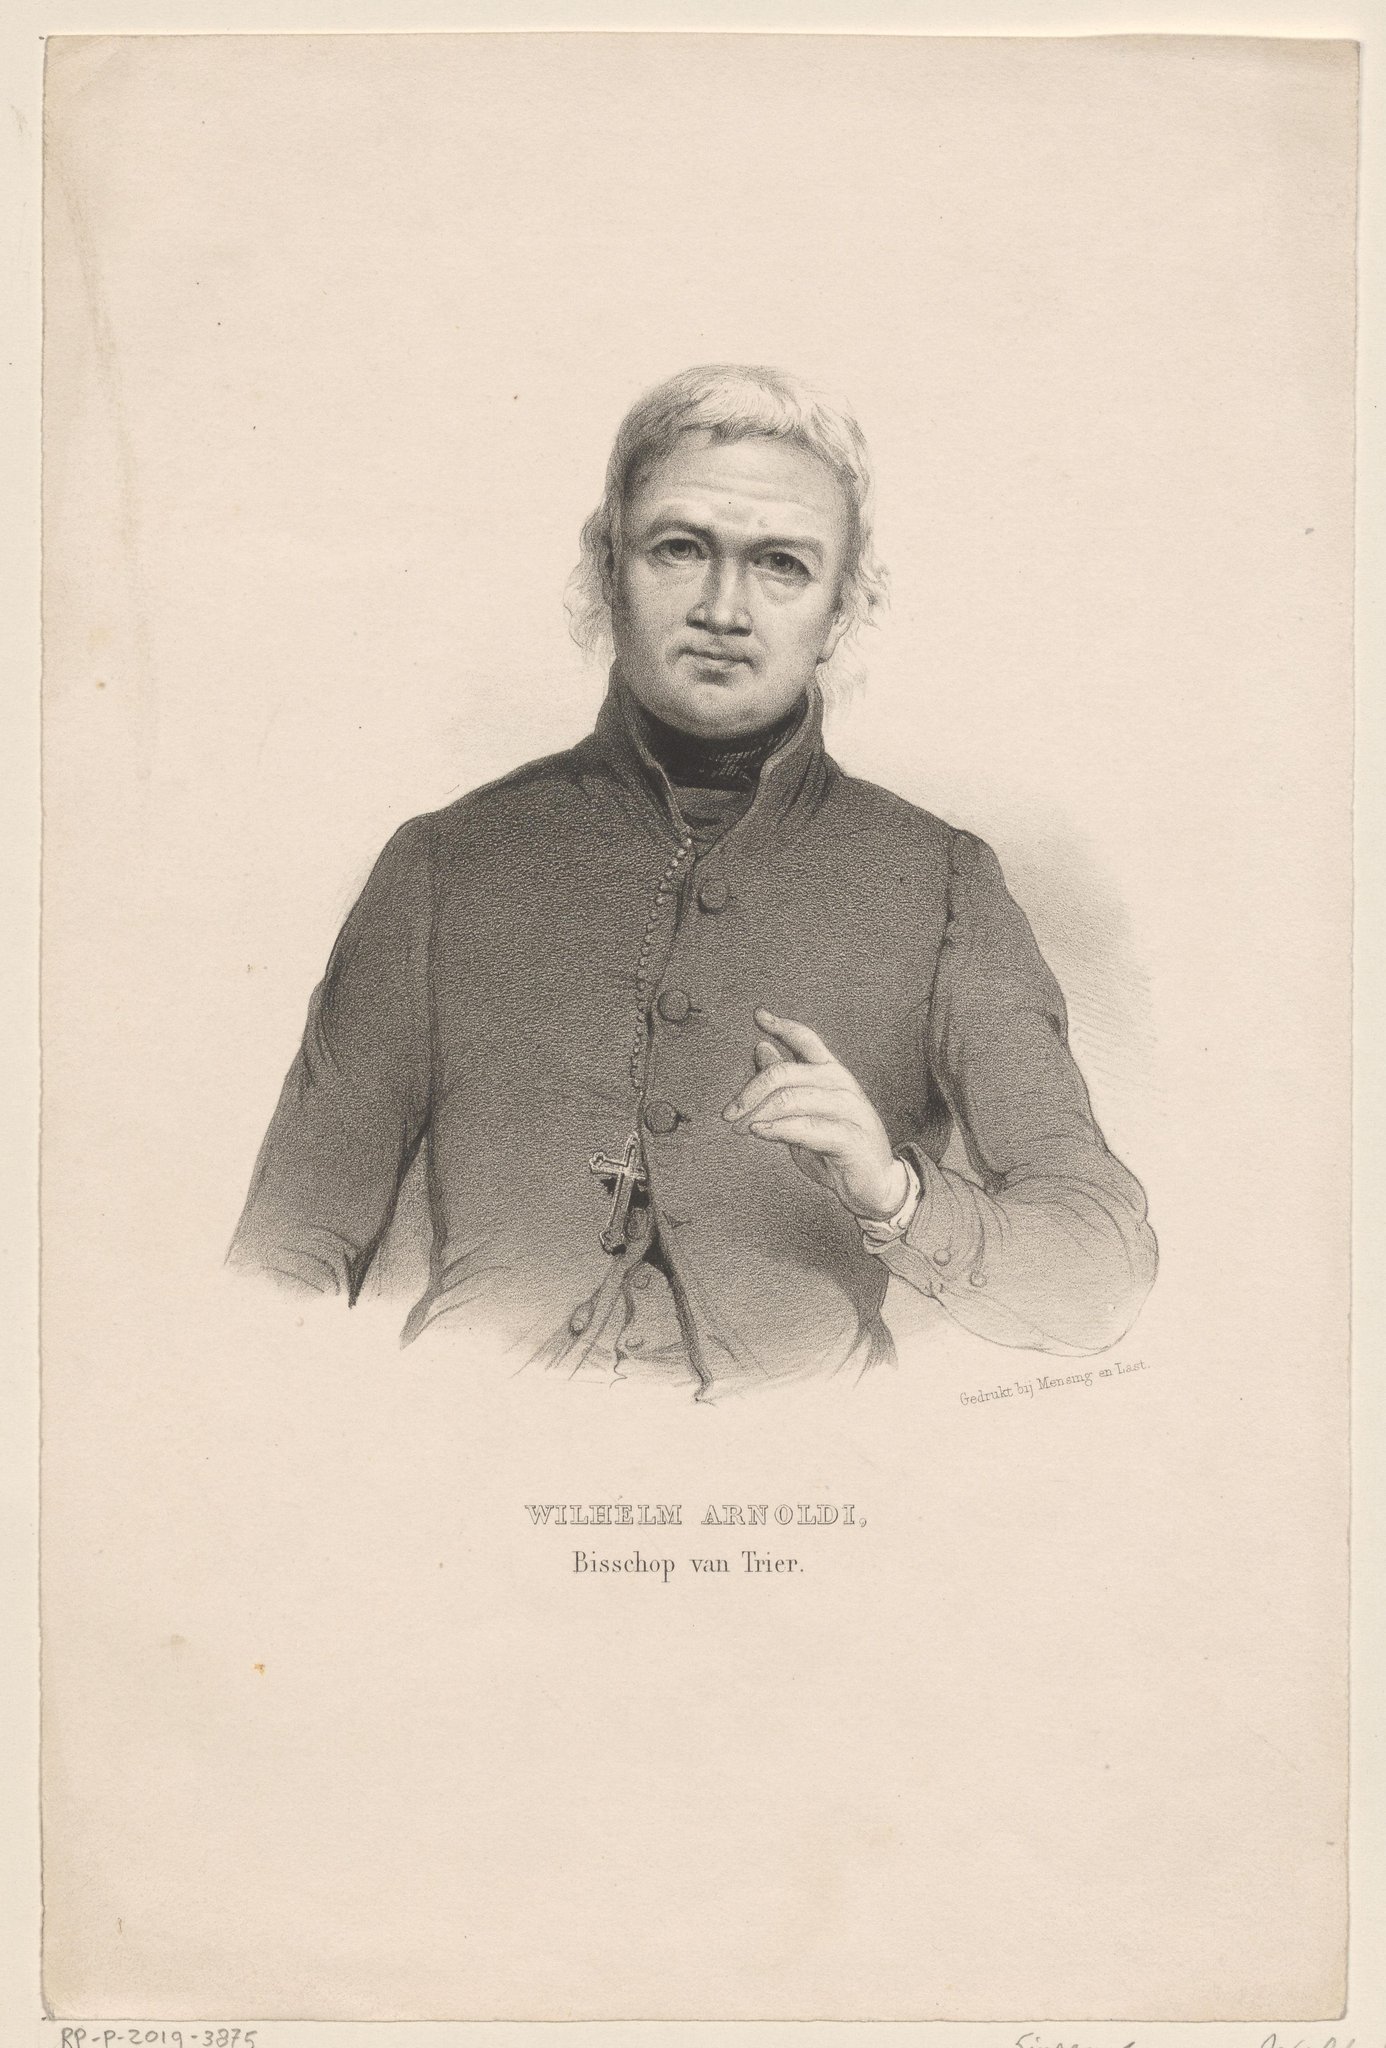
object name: print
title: Portret van Wilhelm Arnoldi, bisschop van Trier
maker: Anonymous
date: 1846-1847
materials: paper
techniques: lithograph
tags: historical persons